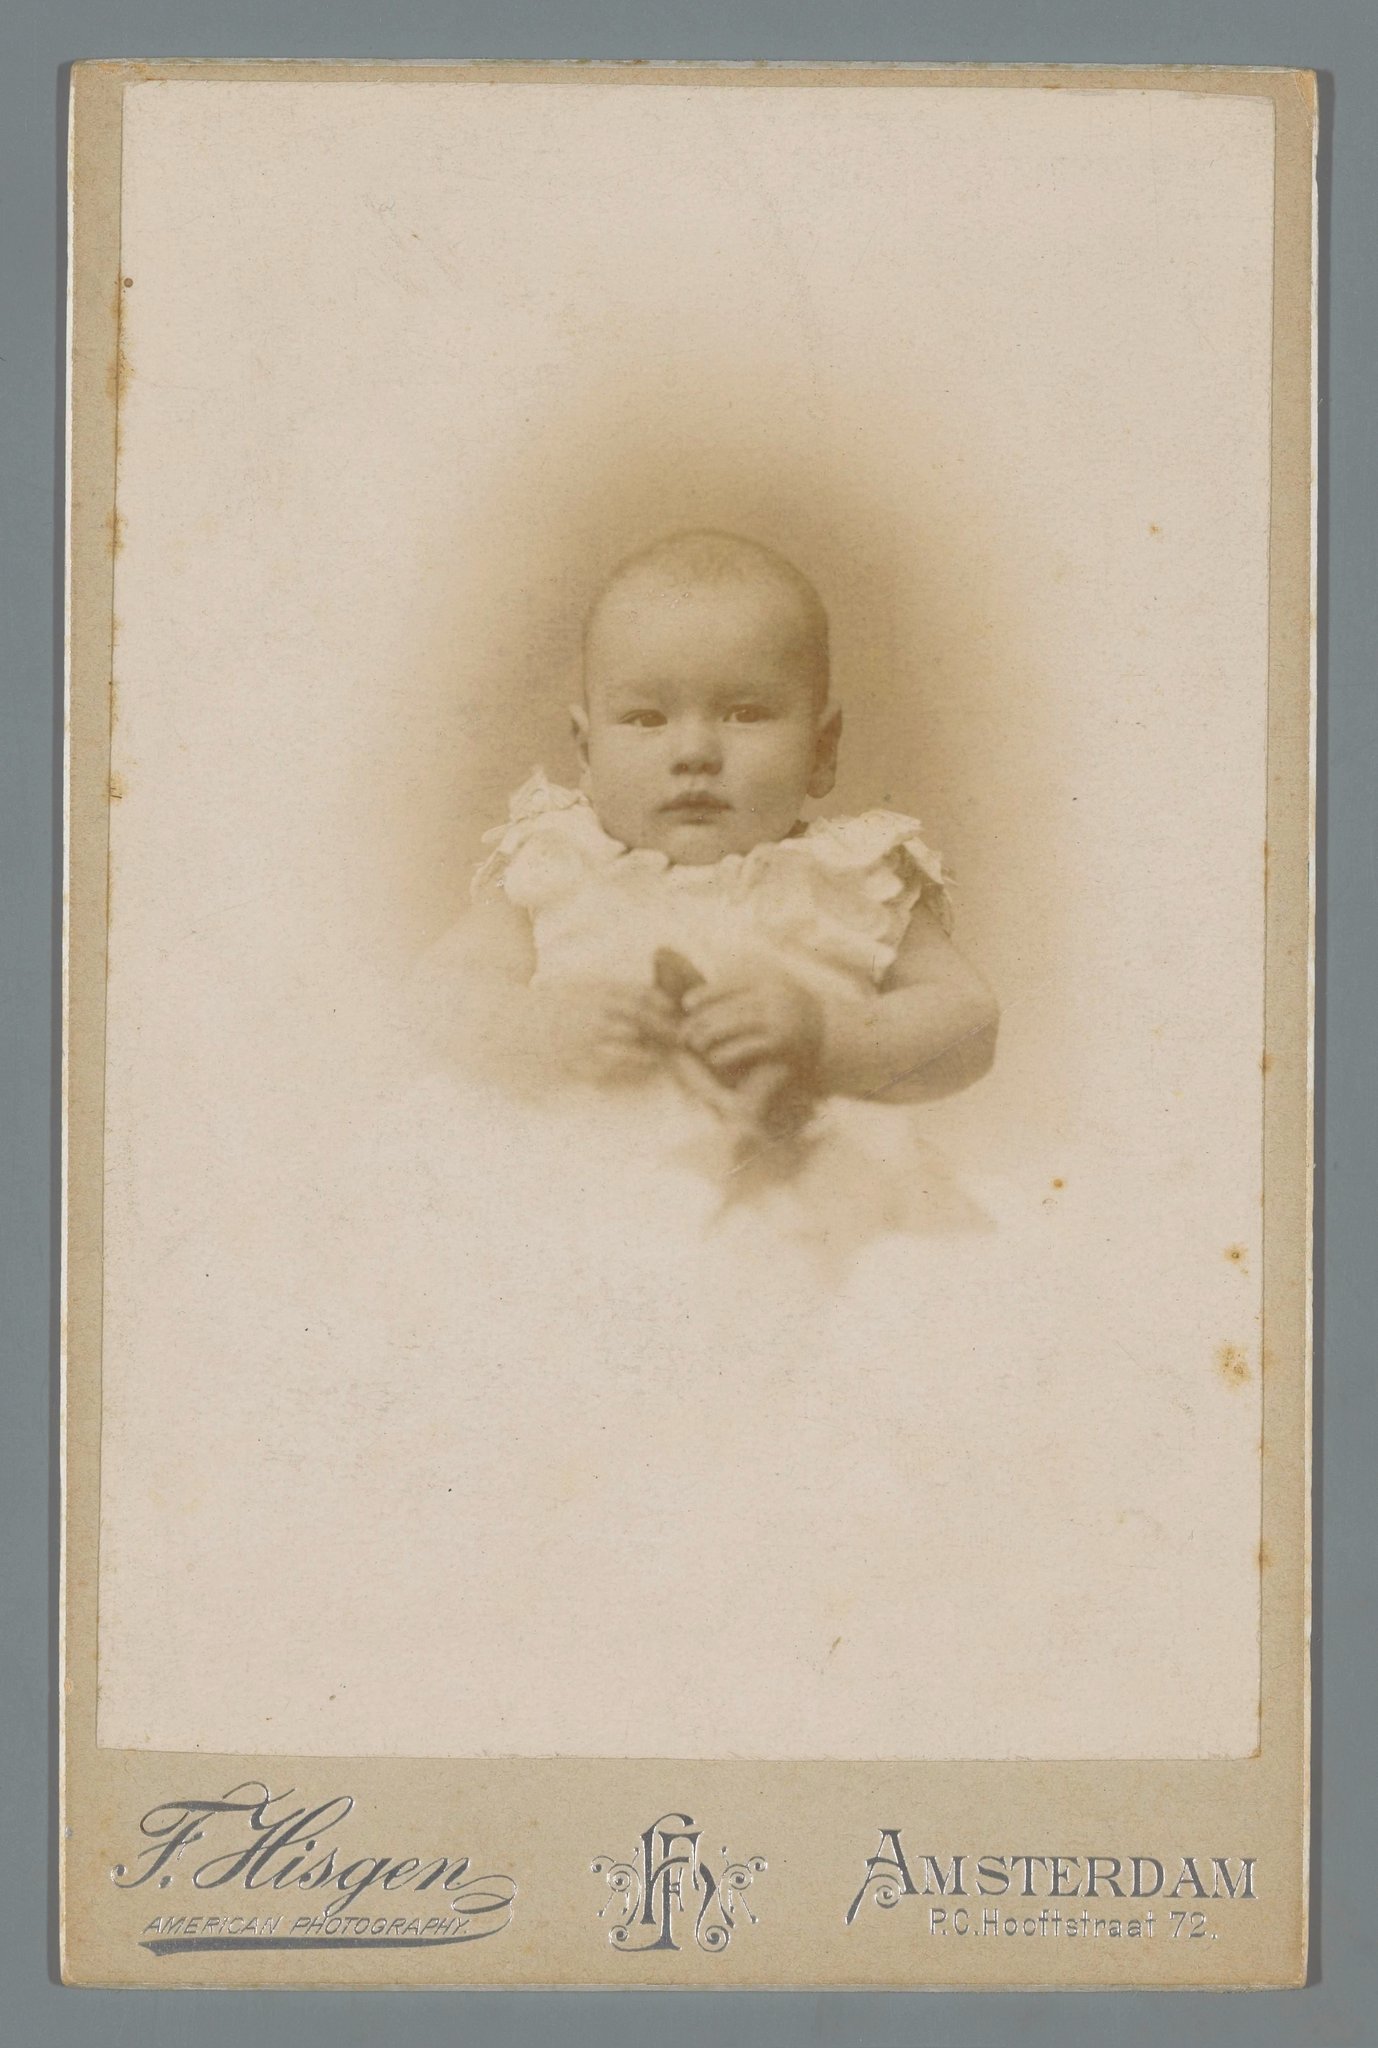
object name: cabinet photograph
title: Portret van een onbekende baby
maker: friedrich carel hisgen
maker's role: fotograaf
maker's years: 1846-1912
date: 1891-1912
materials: cardboard, photographic support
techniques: daylight paper print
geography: amsterdam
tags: infant, baby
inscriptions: name: ‘F. Hisgen American Photography Amsterdam, P.C. Hooftstraat 72.’